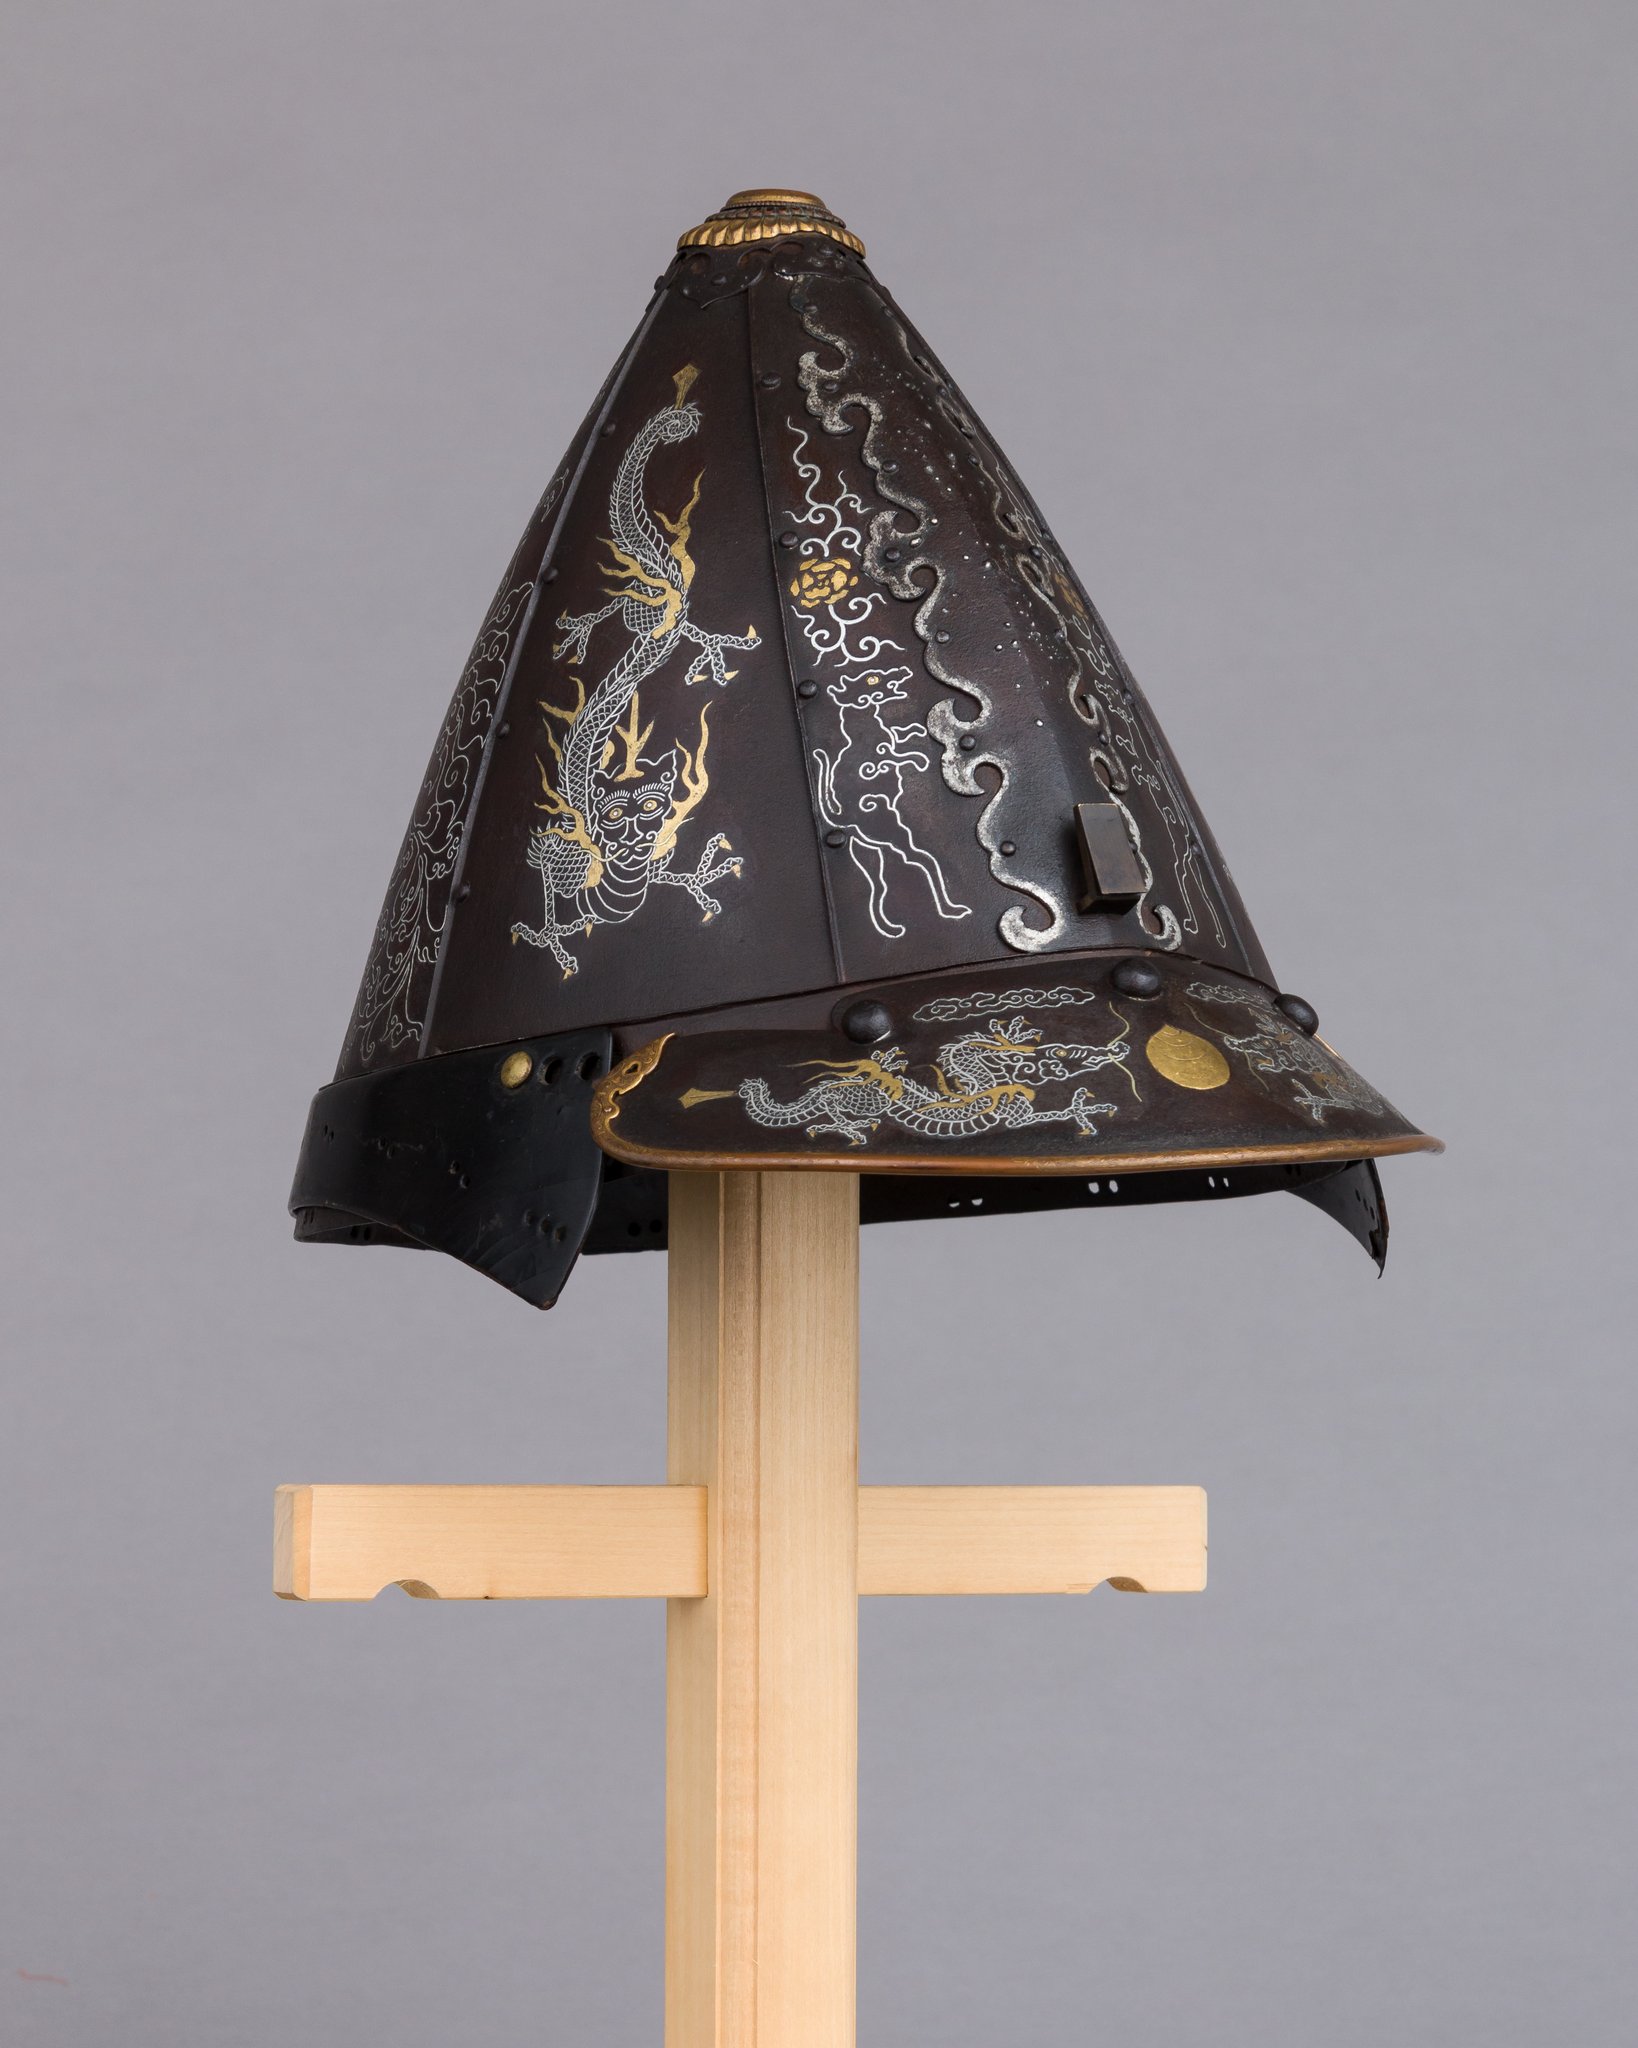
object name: helmet i kawari kabuto i in the korean style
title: Helmet (Kawari-kabuto) in the Korean Style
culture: japanese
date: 1701-1800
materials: copper, gold, iron, lacquer, silver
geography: japan